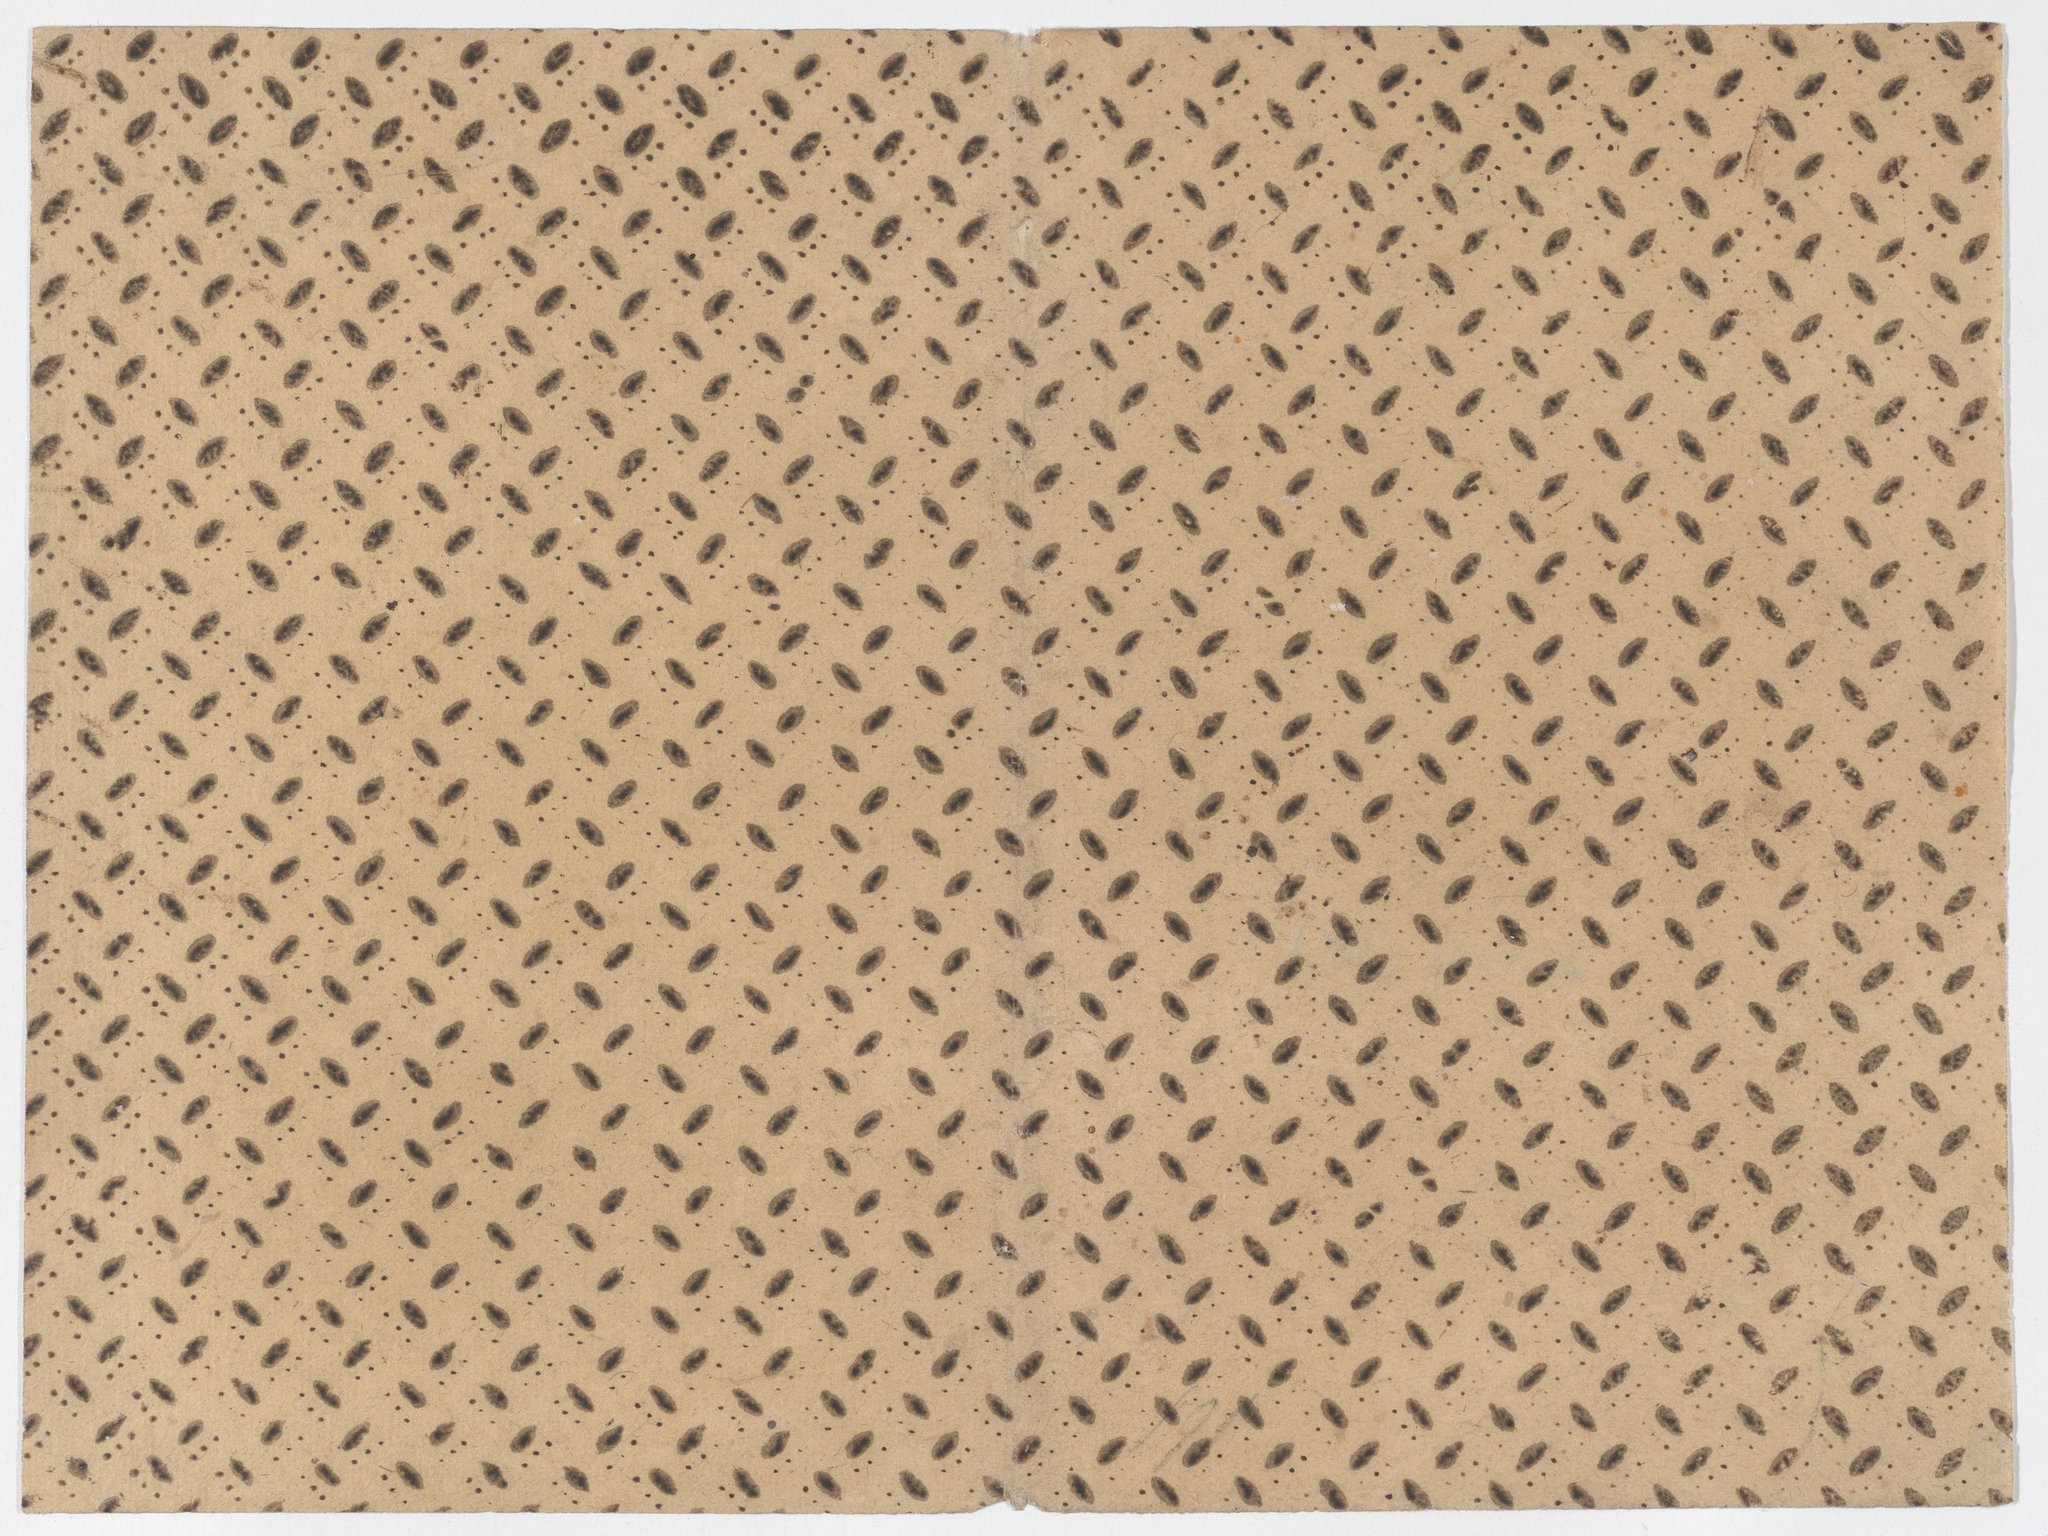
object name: print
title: Sheet with overall pattern of dots and dashes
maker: Anonymous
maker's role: artist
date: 1801-1900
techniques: relief print